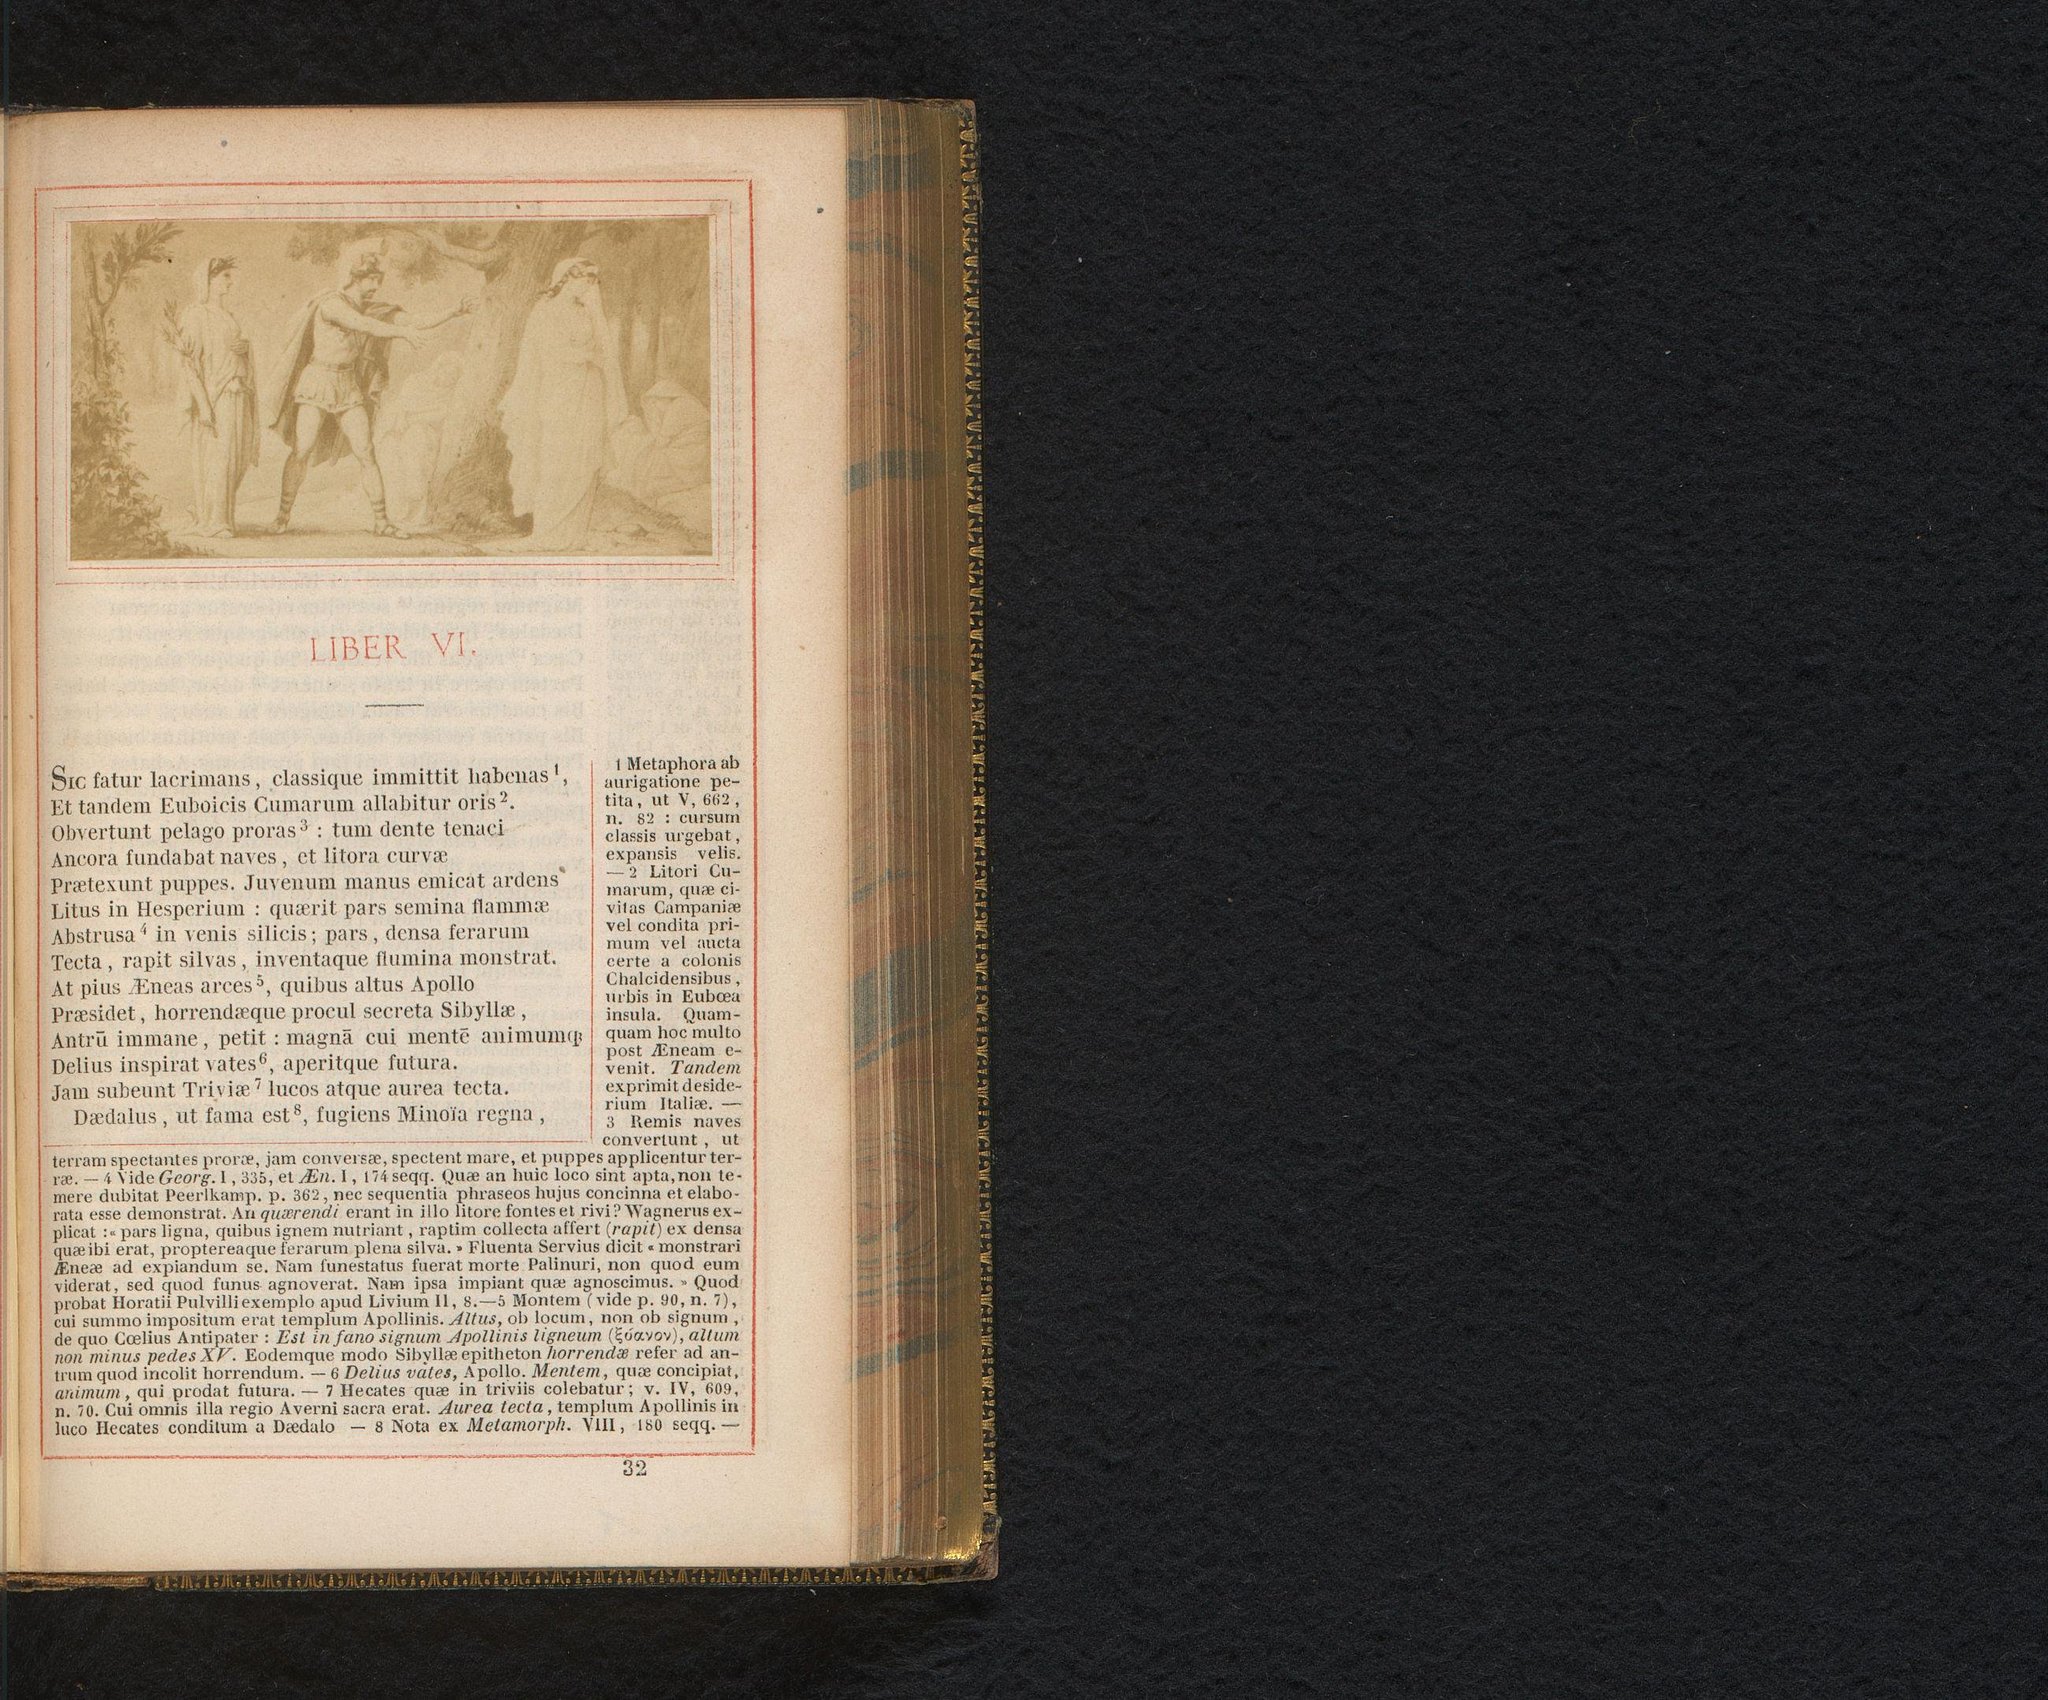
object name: photograph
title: Fotoreproductie van een schilderij, voorstellende Aeneas ziet de schim van Dido in de onderwereld, scène uit Virgilius' Aeneis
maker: Anonymous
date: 1853-1858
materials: paper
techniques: albumen print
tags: aeneas and the sibyl meet various groups of the dead, among them is dido, who turns aside